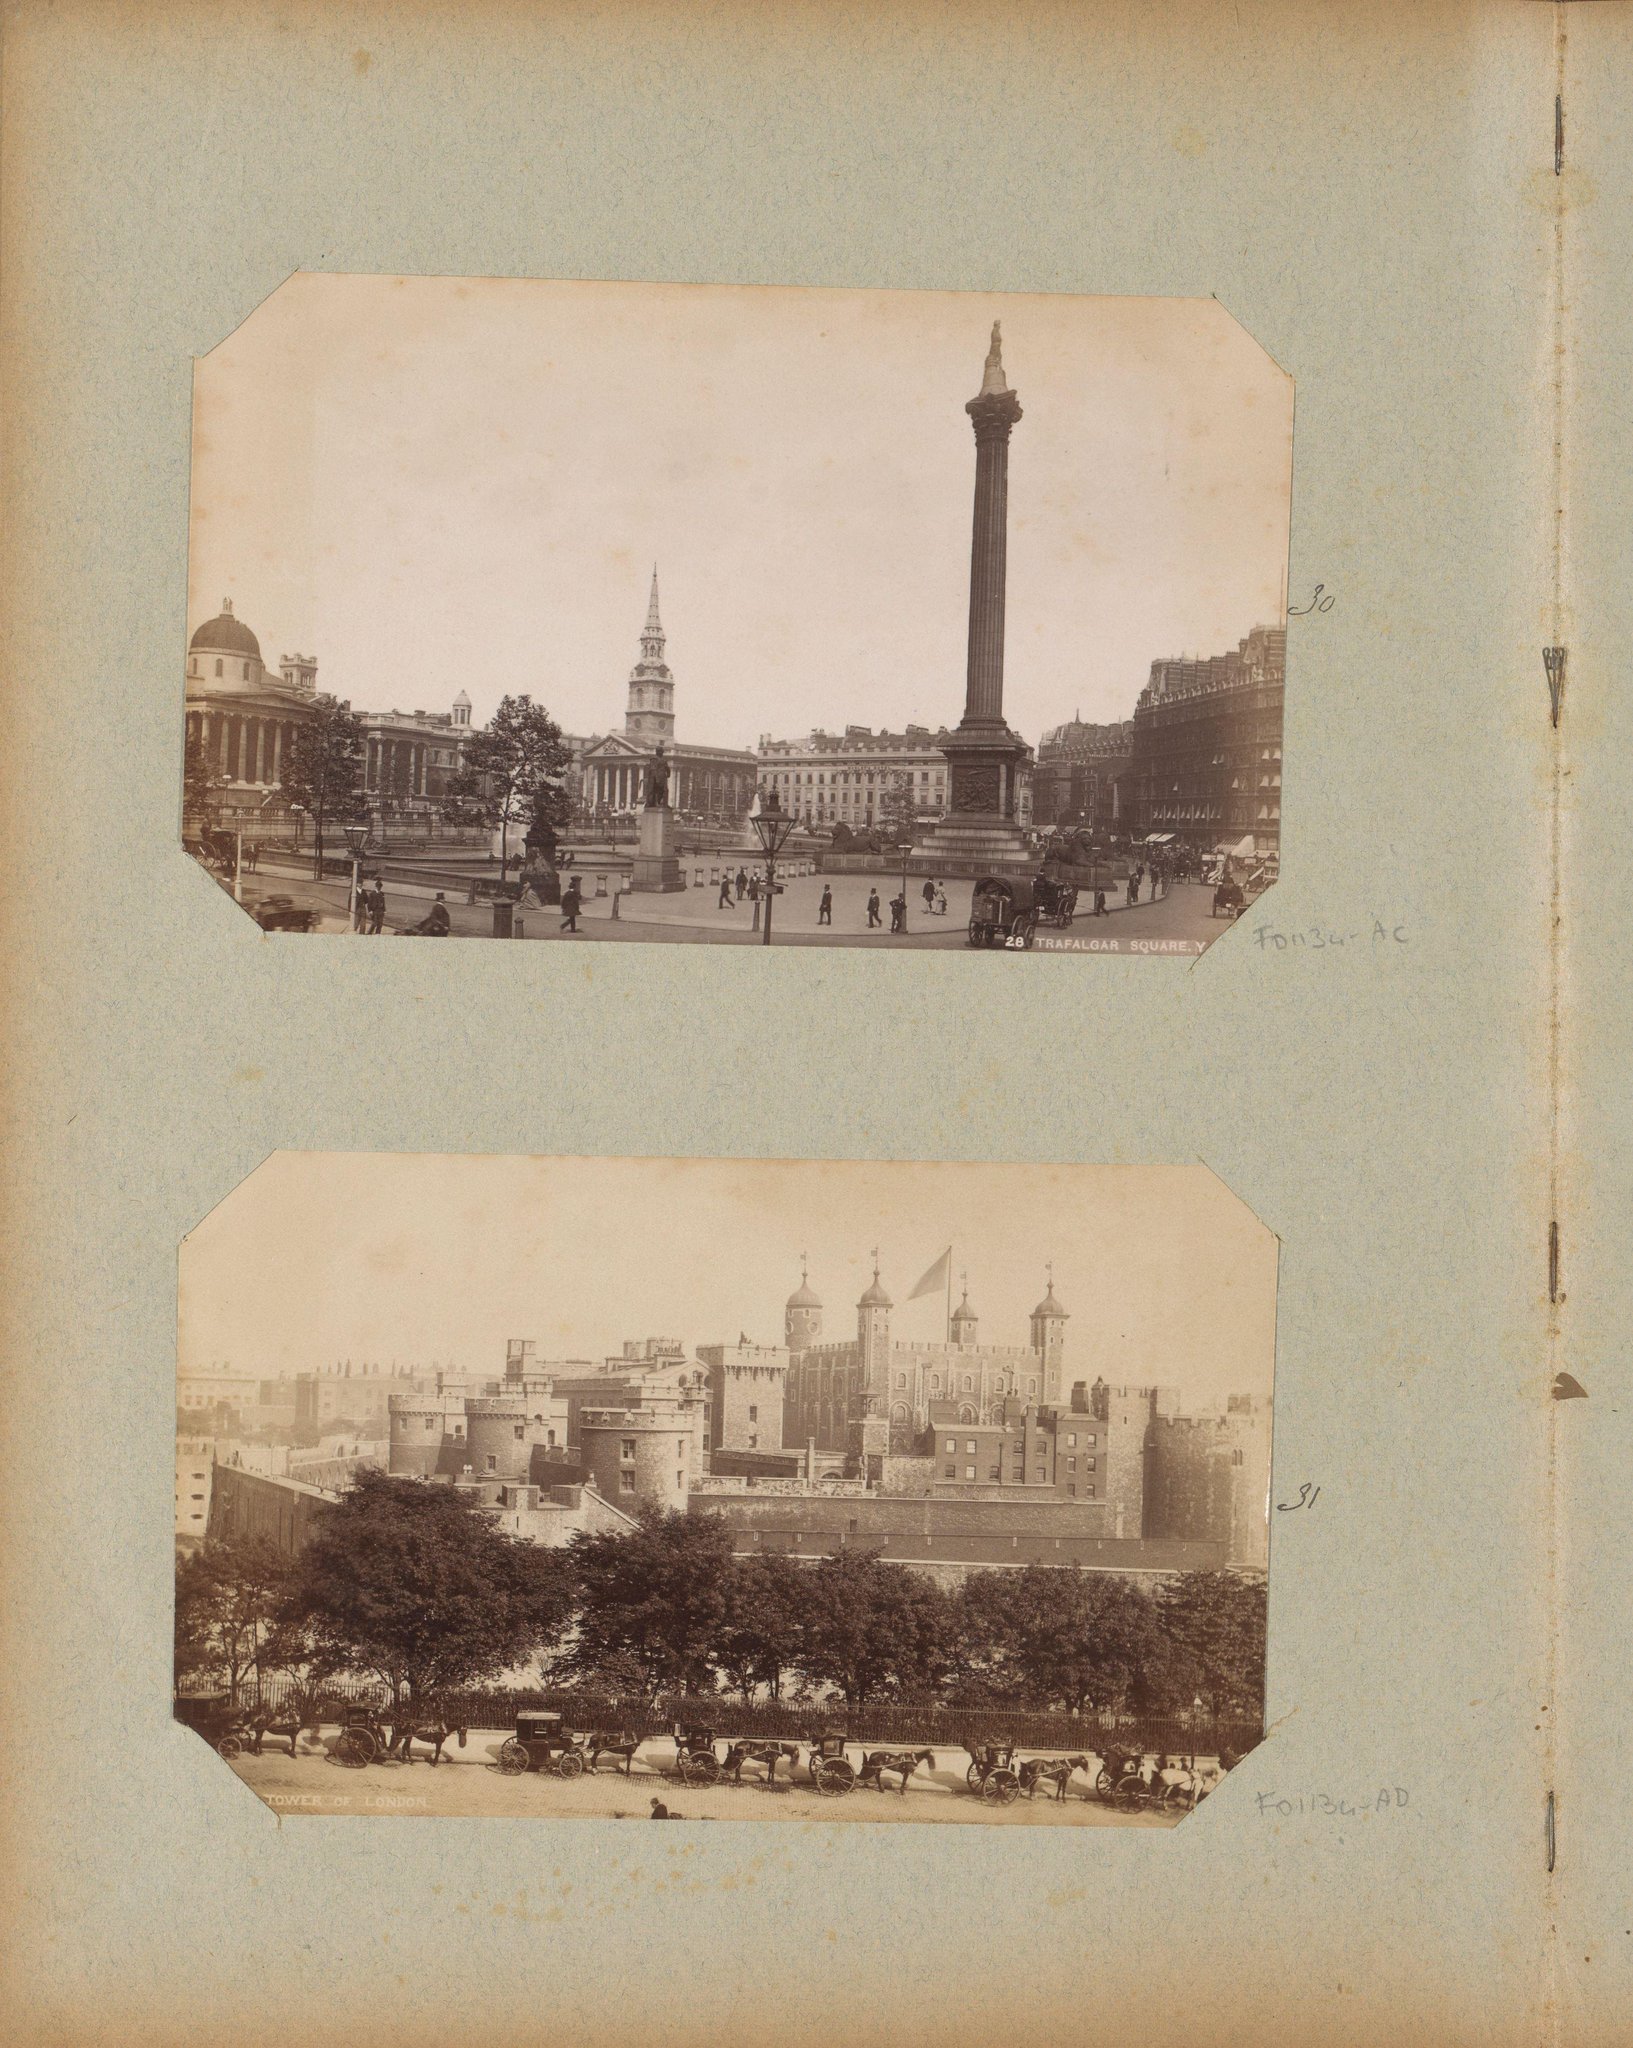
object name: album leaf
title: The Tower of London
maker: Anonymous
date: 1880-1910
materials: paper, photographic support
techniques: albumen print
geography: london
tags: castle, two-wheeled, animal-drawn vehicle, four-wheeled, animal-drawn vehicle, e.g.: cab, carriage, coach, london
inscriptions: negative number: ‘36’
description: Onderdeel van Reisalbum met bezienswaardigheden in Engeland, Zwitserland, Frankrijk en Duitsland.